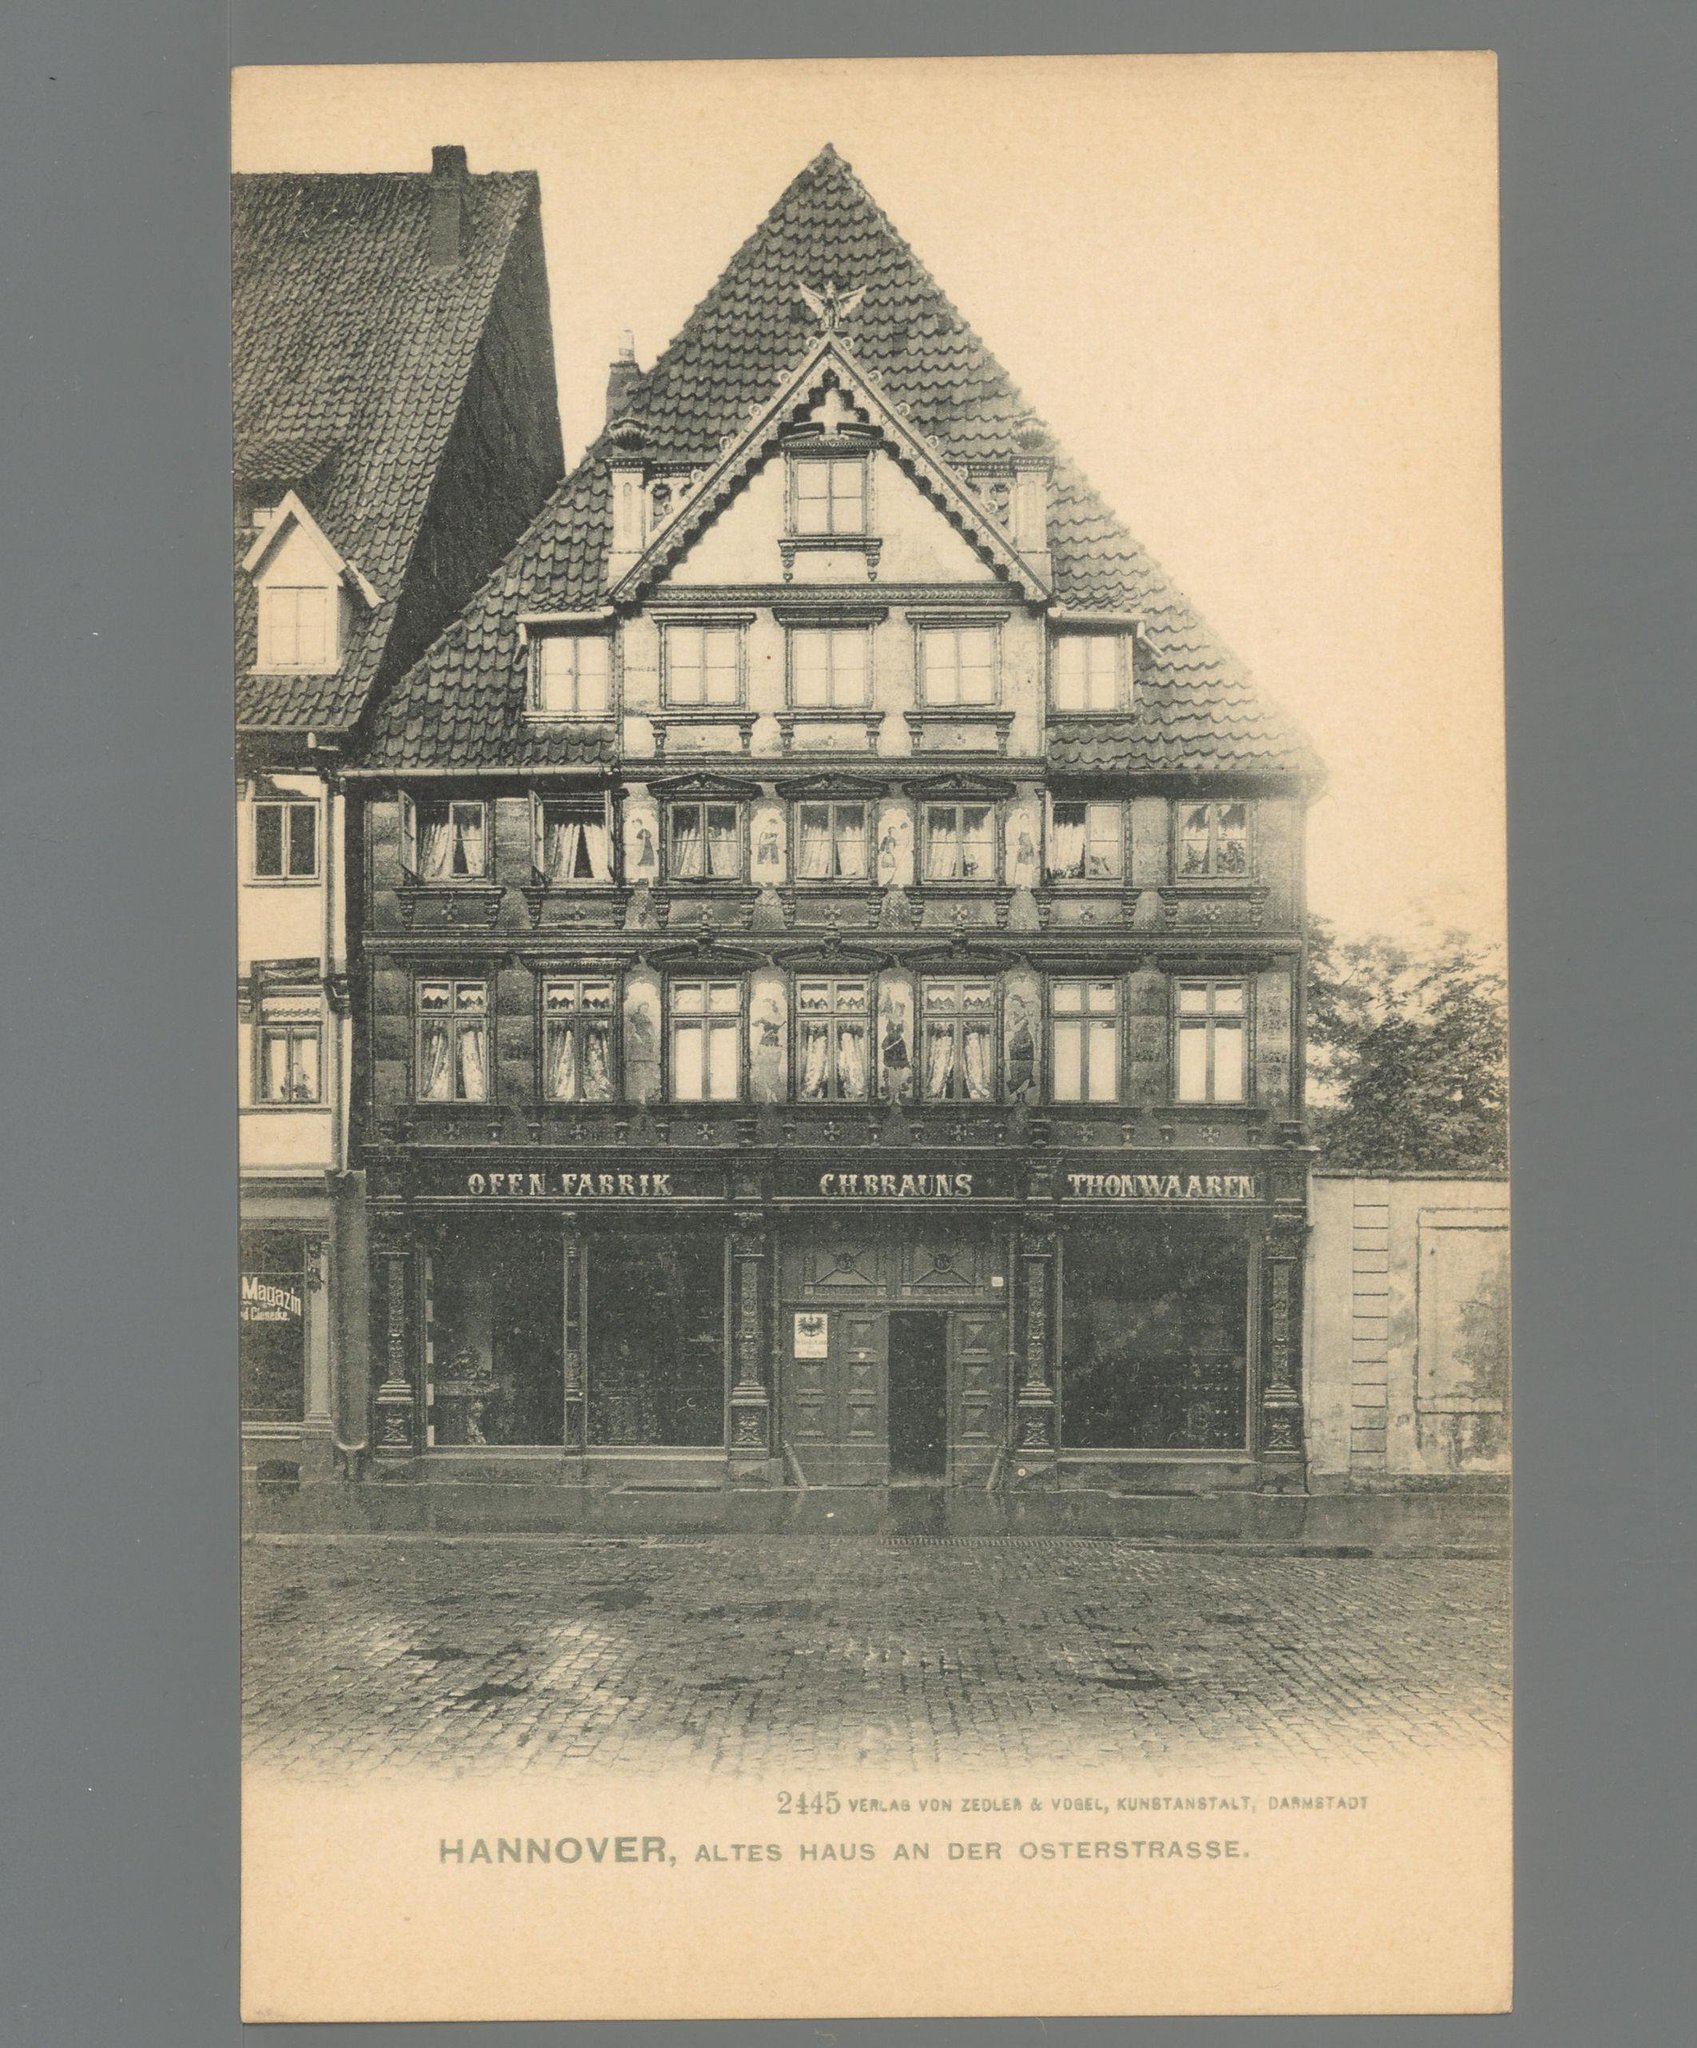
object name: ansichtkaart, prentbriefkaart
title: Hannover, Altes Haus an der Osterstrasse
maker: Anonymous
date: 1905-1930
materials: cardboard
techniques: photograph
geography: hannover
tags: shop, store